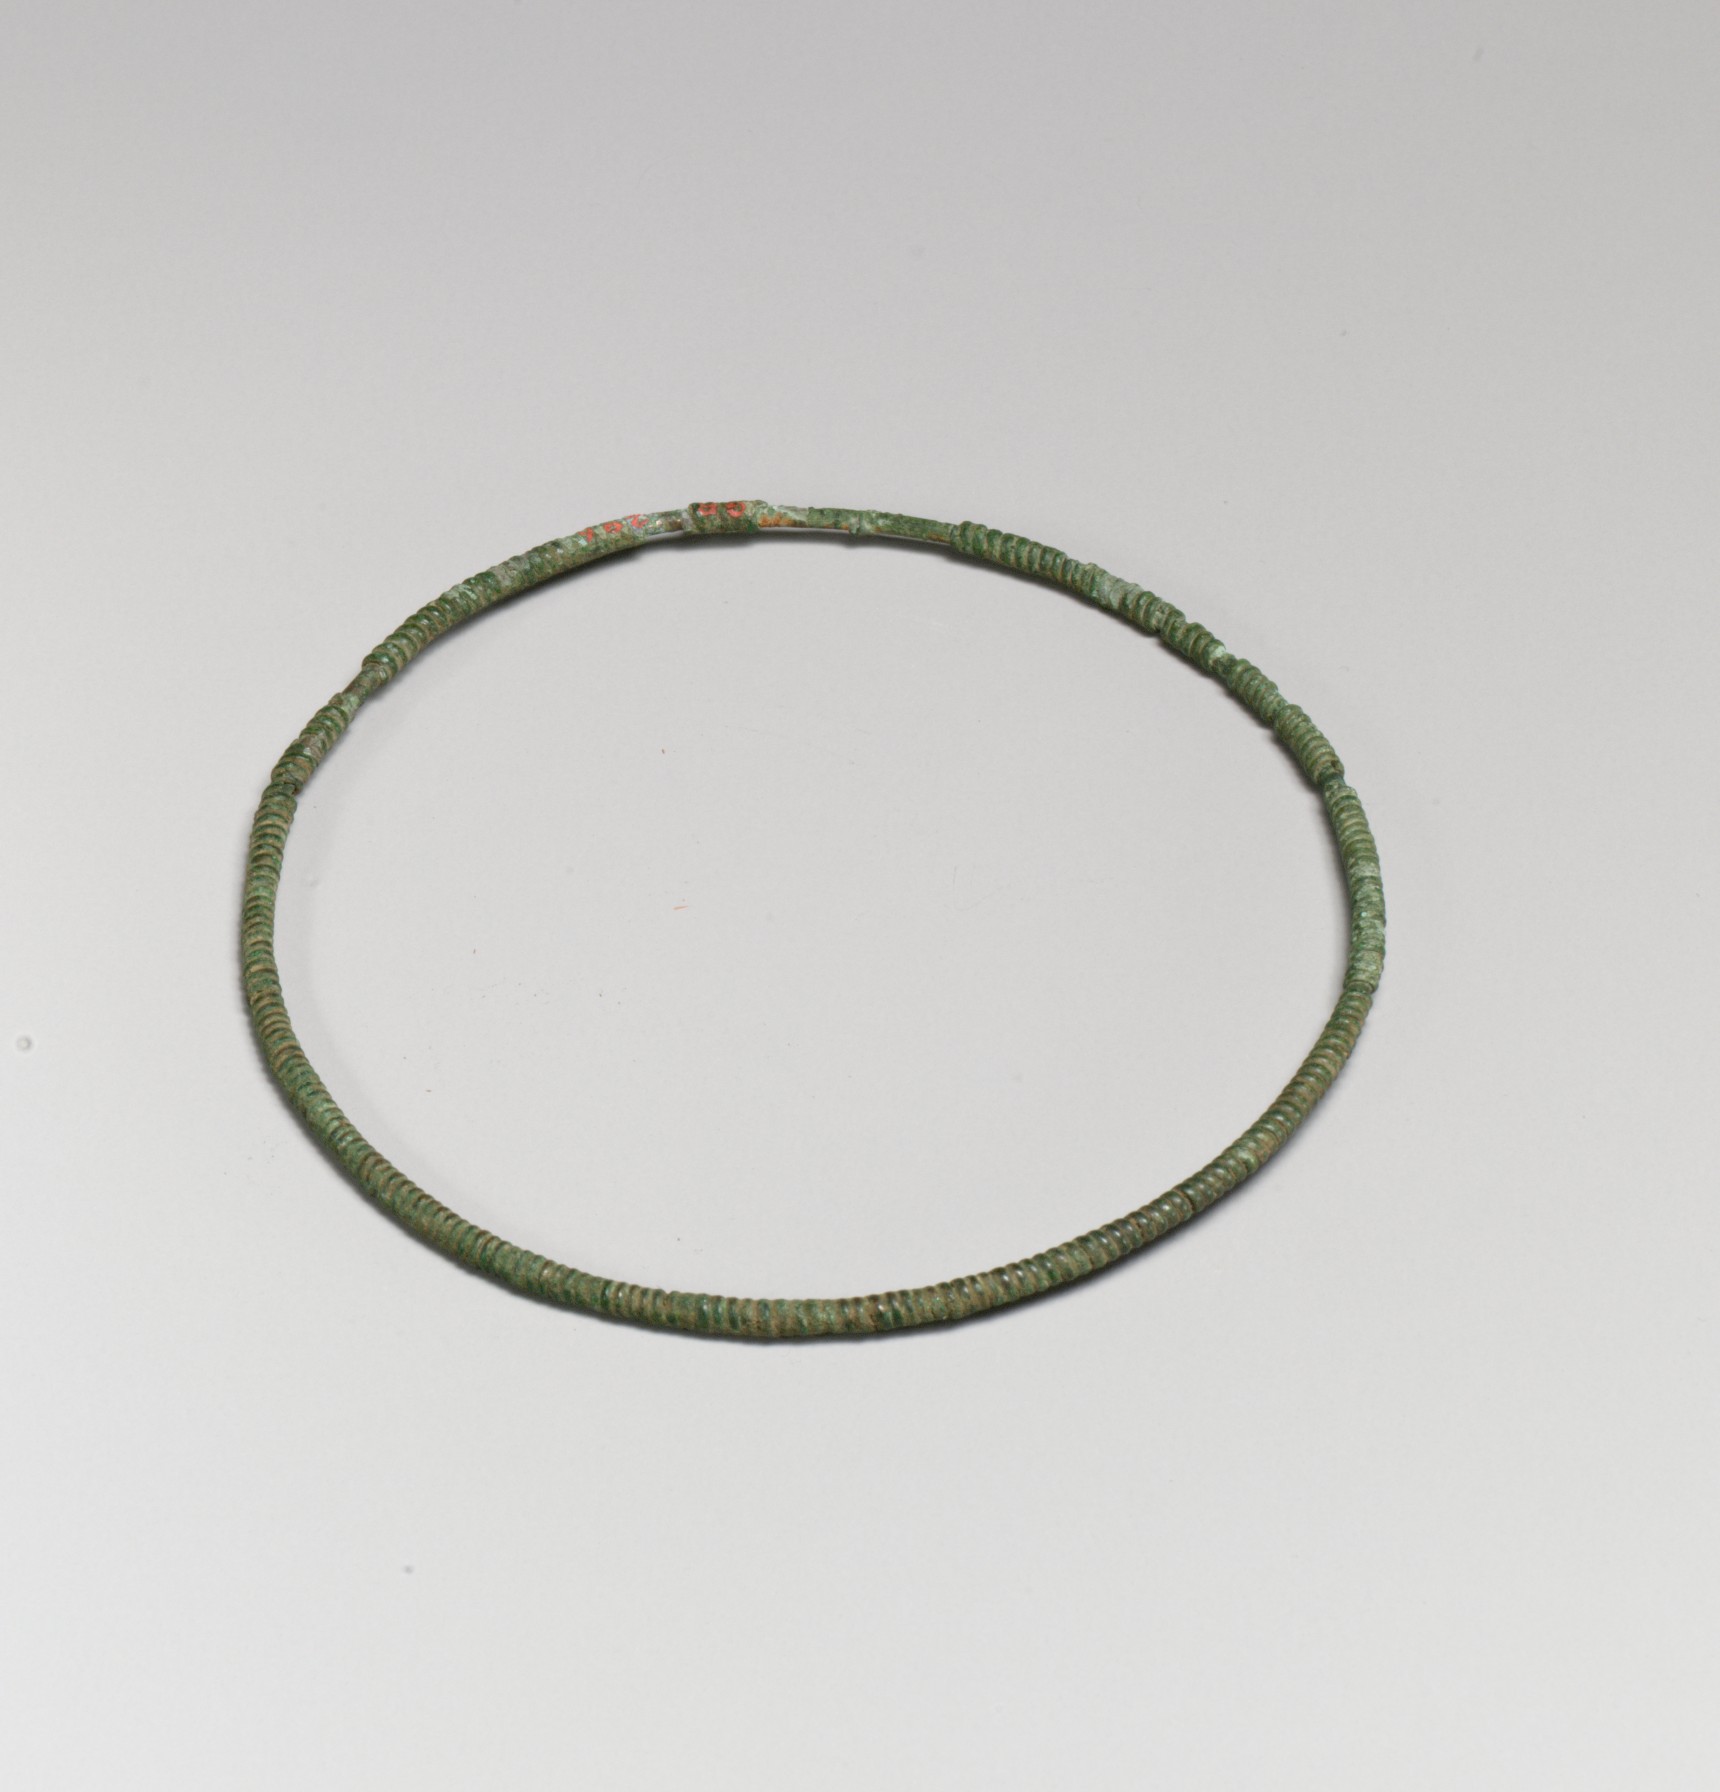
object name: bracelet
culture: roman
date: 1-300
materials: bronze